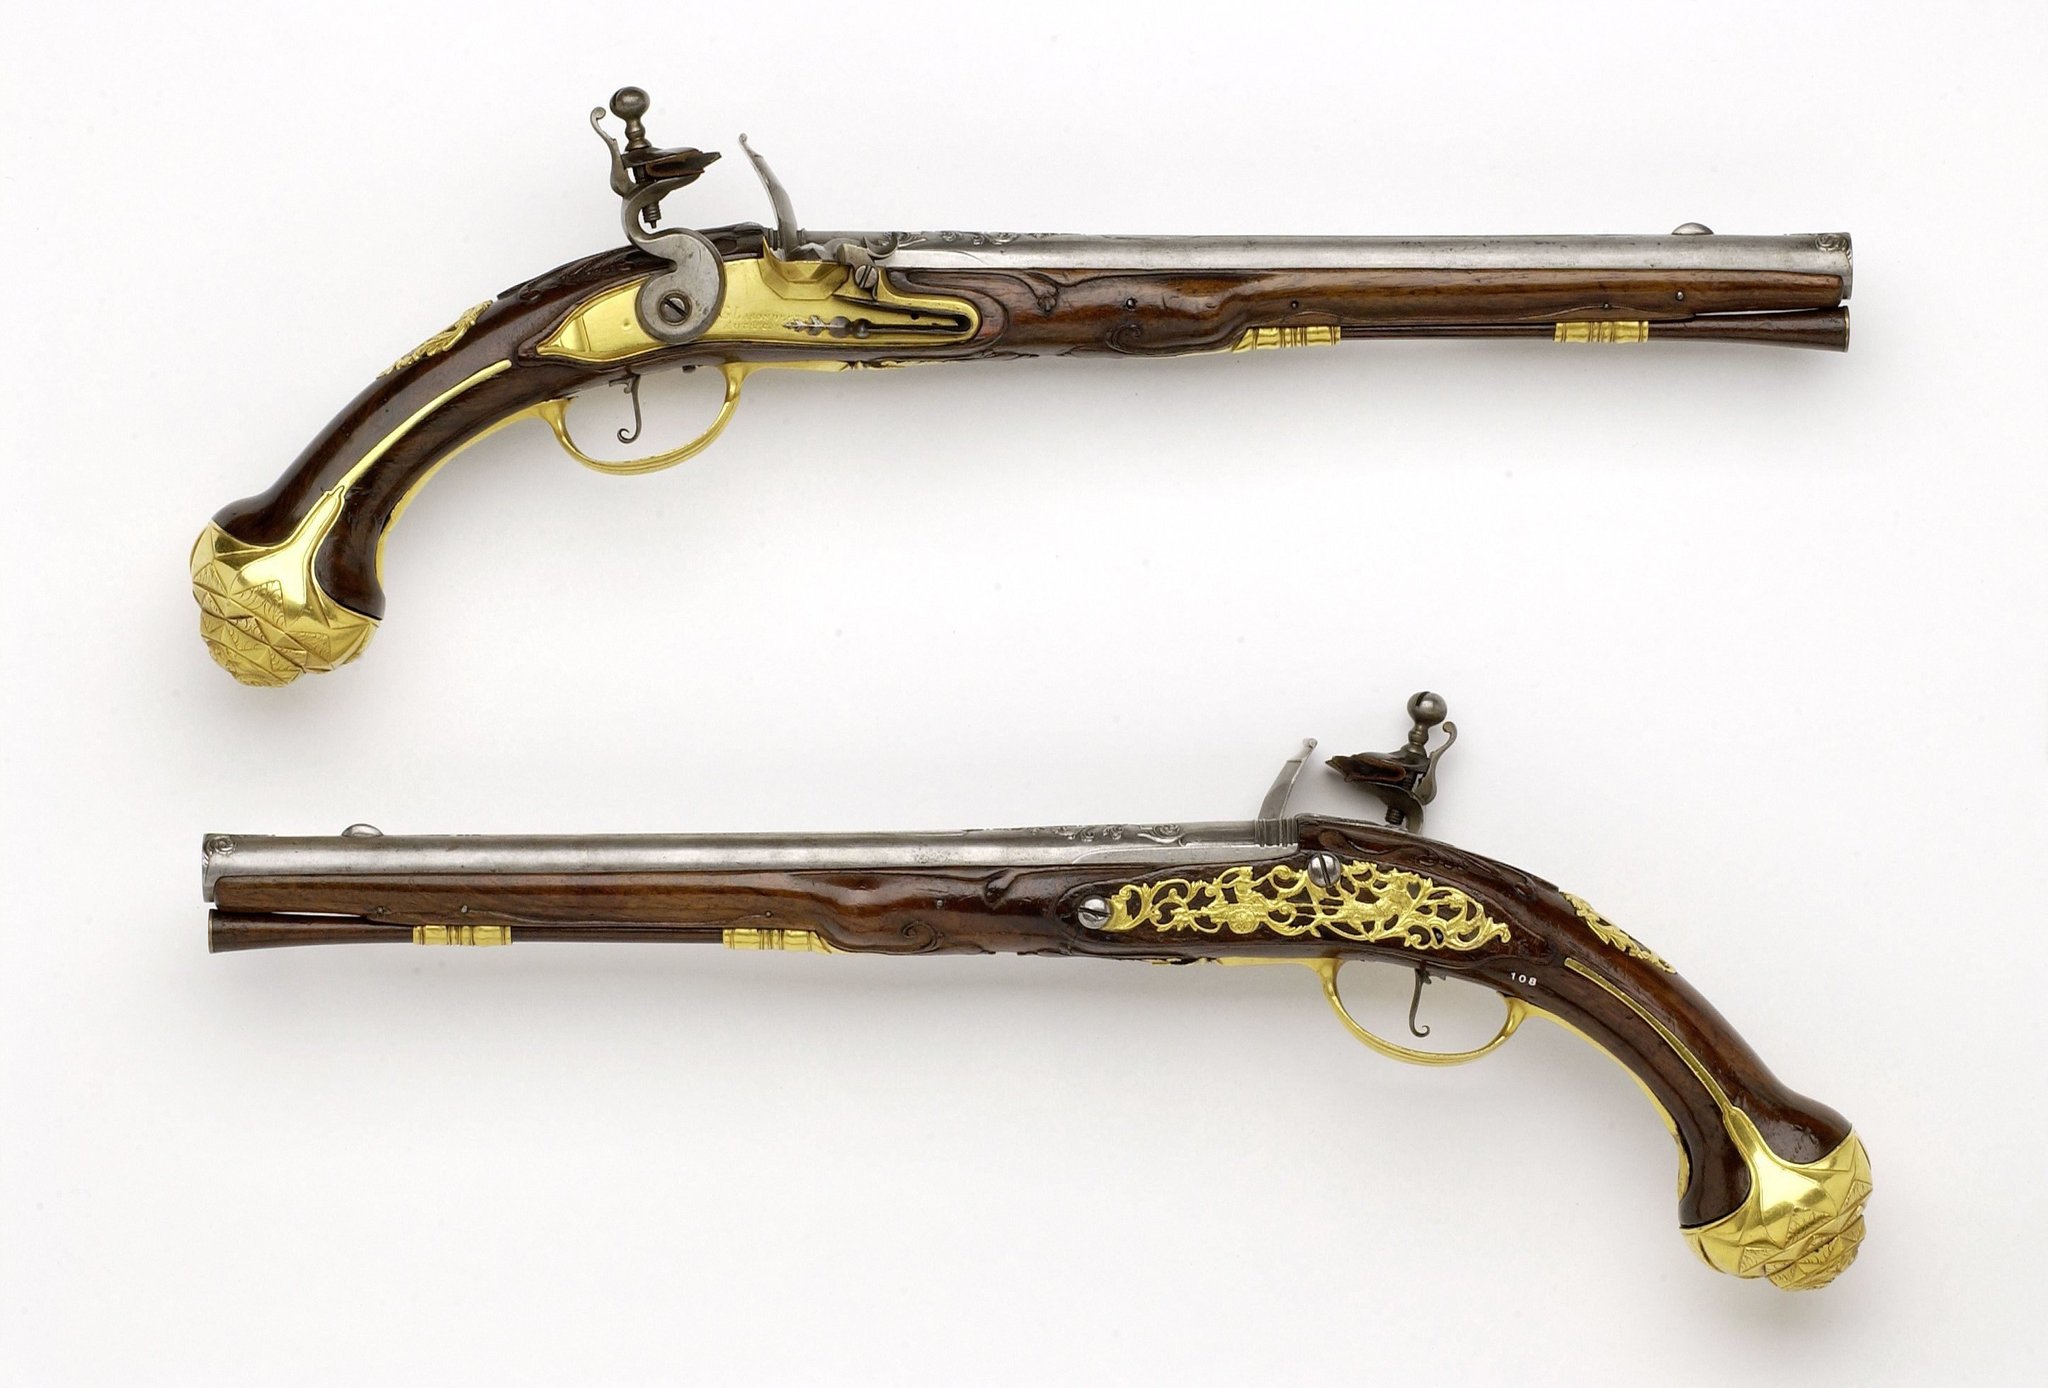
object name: flintlock pistol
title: Vuursteenpistool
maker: gerrit lasonder (ii)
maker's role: geweermaker, pistoolmaker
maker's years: -1732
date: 1710-1720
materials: brass, iron, wood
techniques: cutting, embroidery, engraving, gilding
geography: utrecht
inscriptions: mark, inscription: ‘G.LASONDER // AUTRECHT’